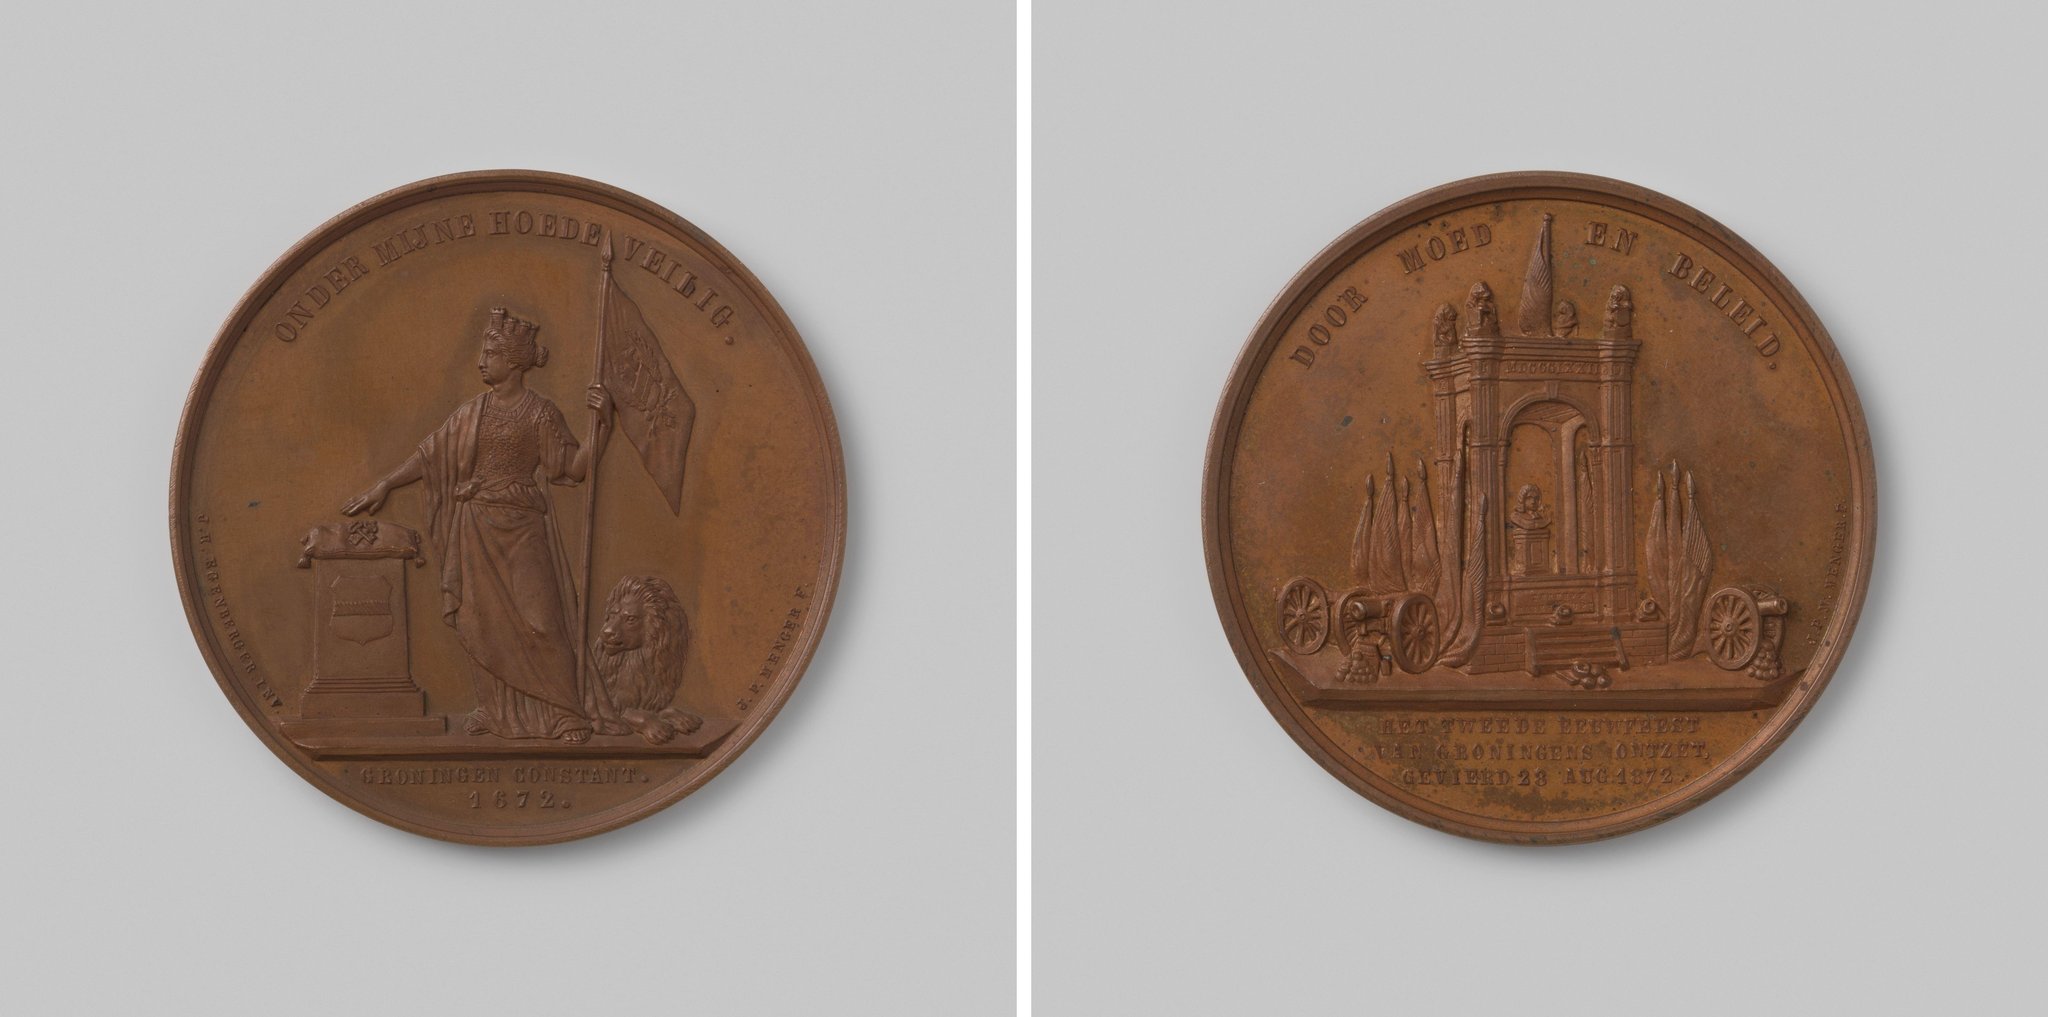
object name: history medal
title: Tweede eeuwfeest van het ontzet van Groningen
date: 1872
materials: bronze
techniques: striking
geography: utrecht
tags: bohemen, coevorden, gouverneur, karl rabenhaupt (baron von sucha), groningen, beleg van groningen (1672)